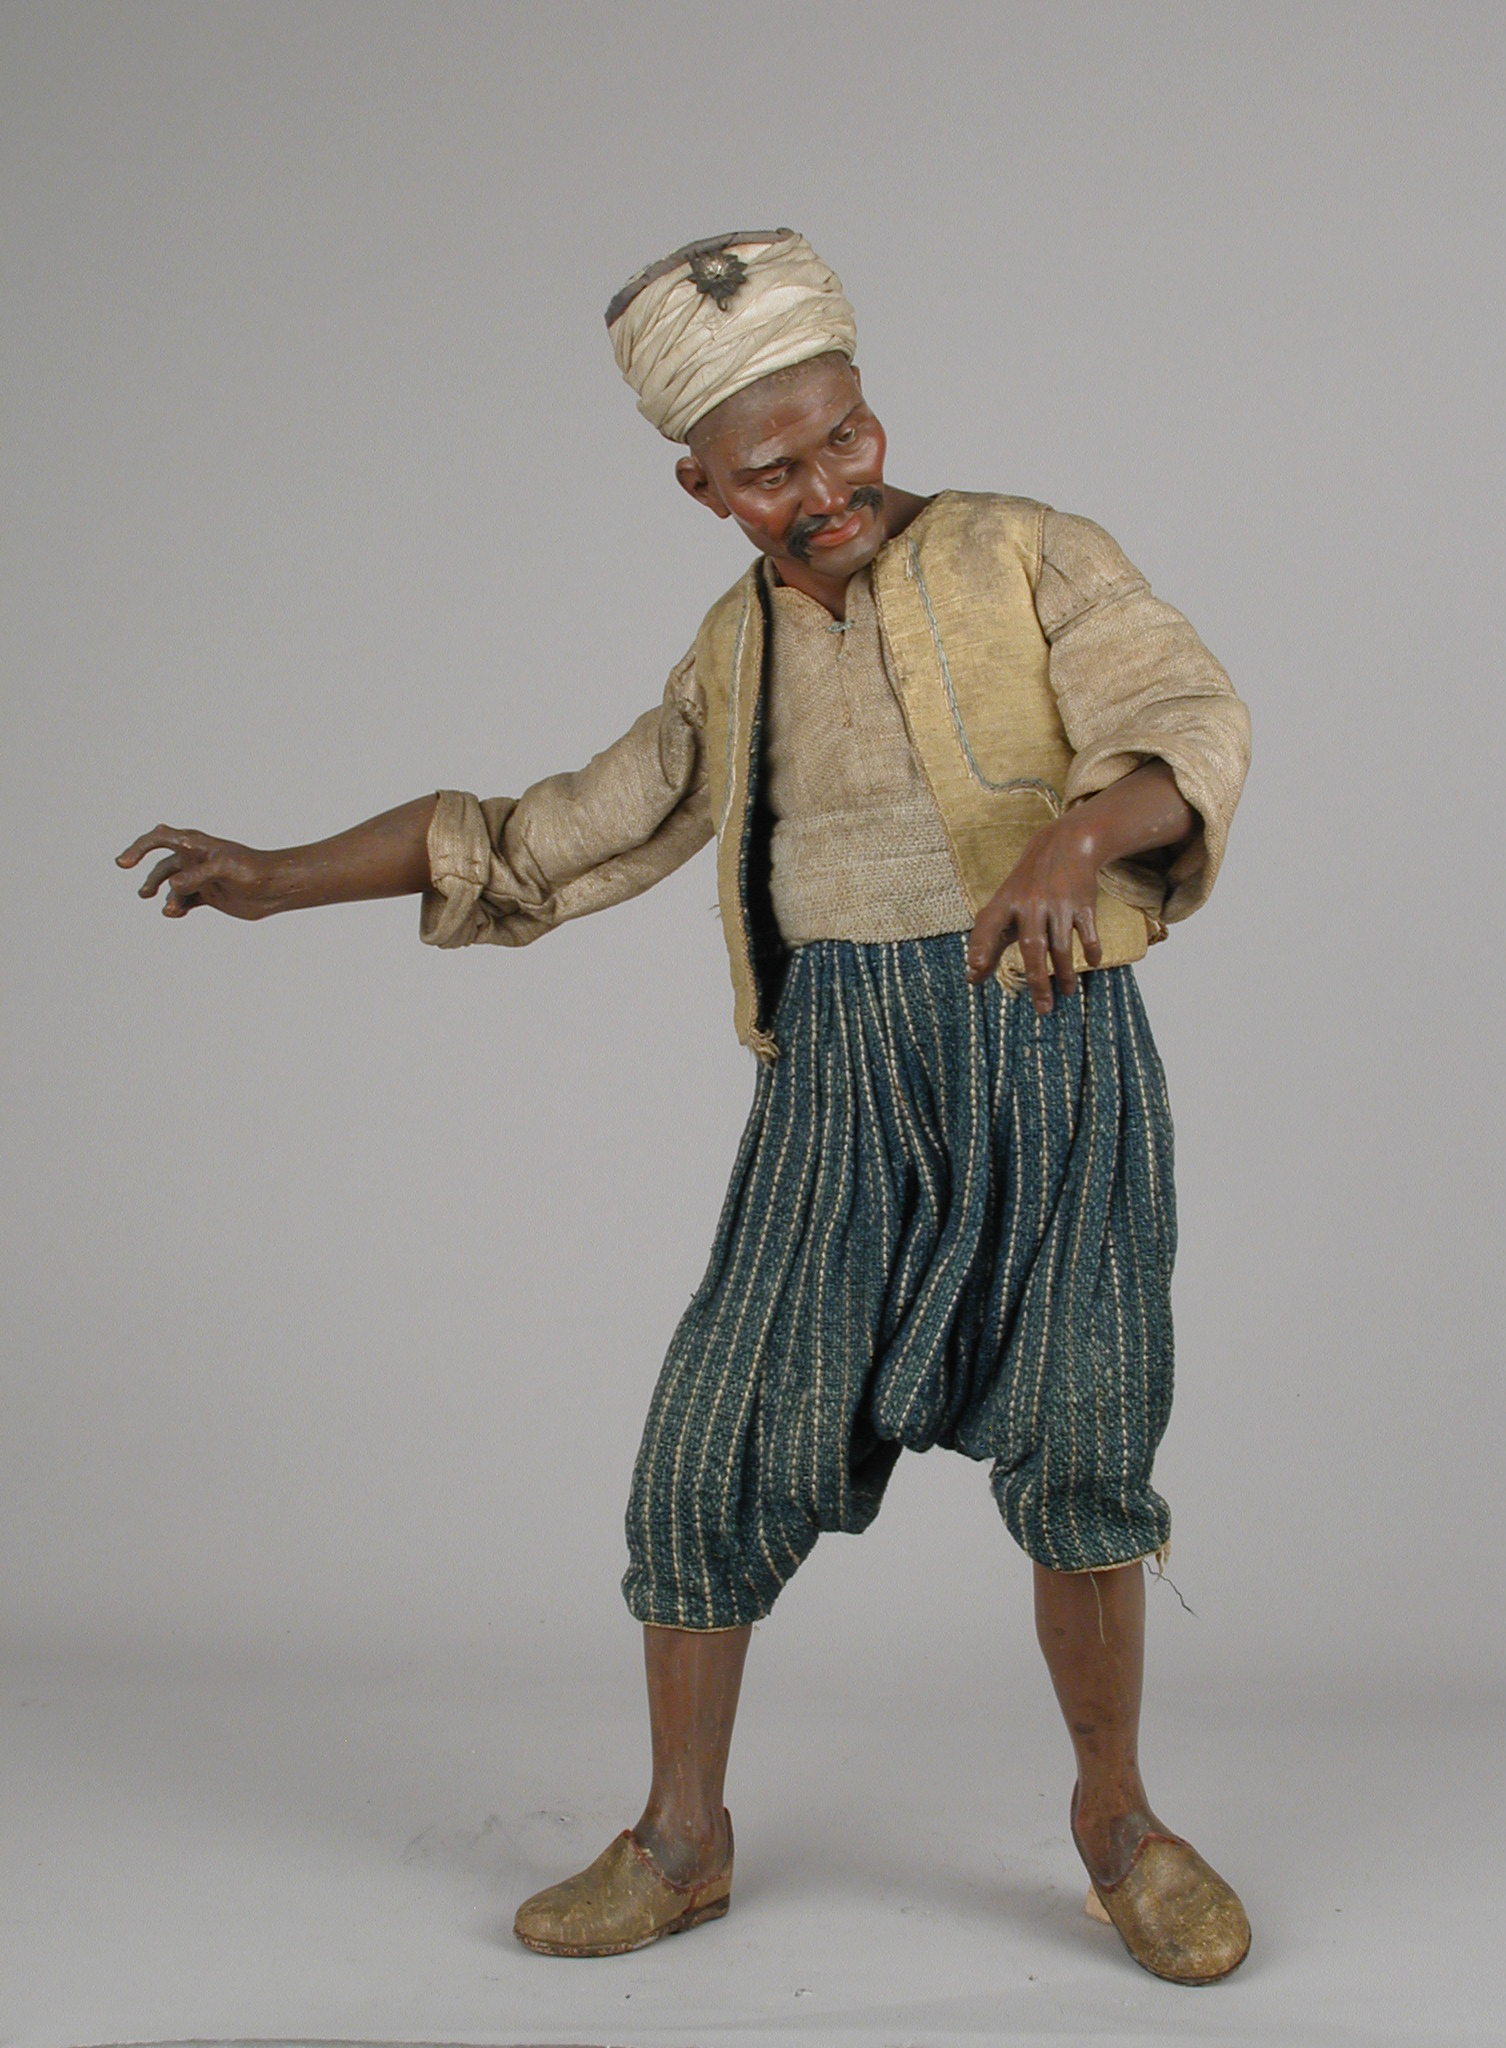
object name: crèche figure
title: Oriental attendant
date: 1751-1800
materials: linen, silk, terracotta, fiber, metal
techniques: polychrome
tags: men